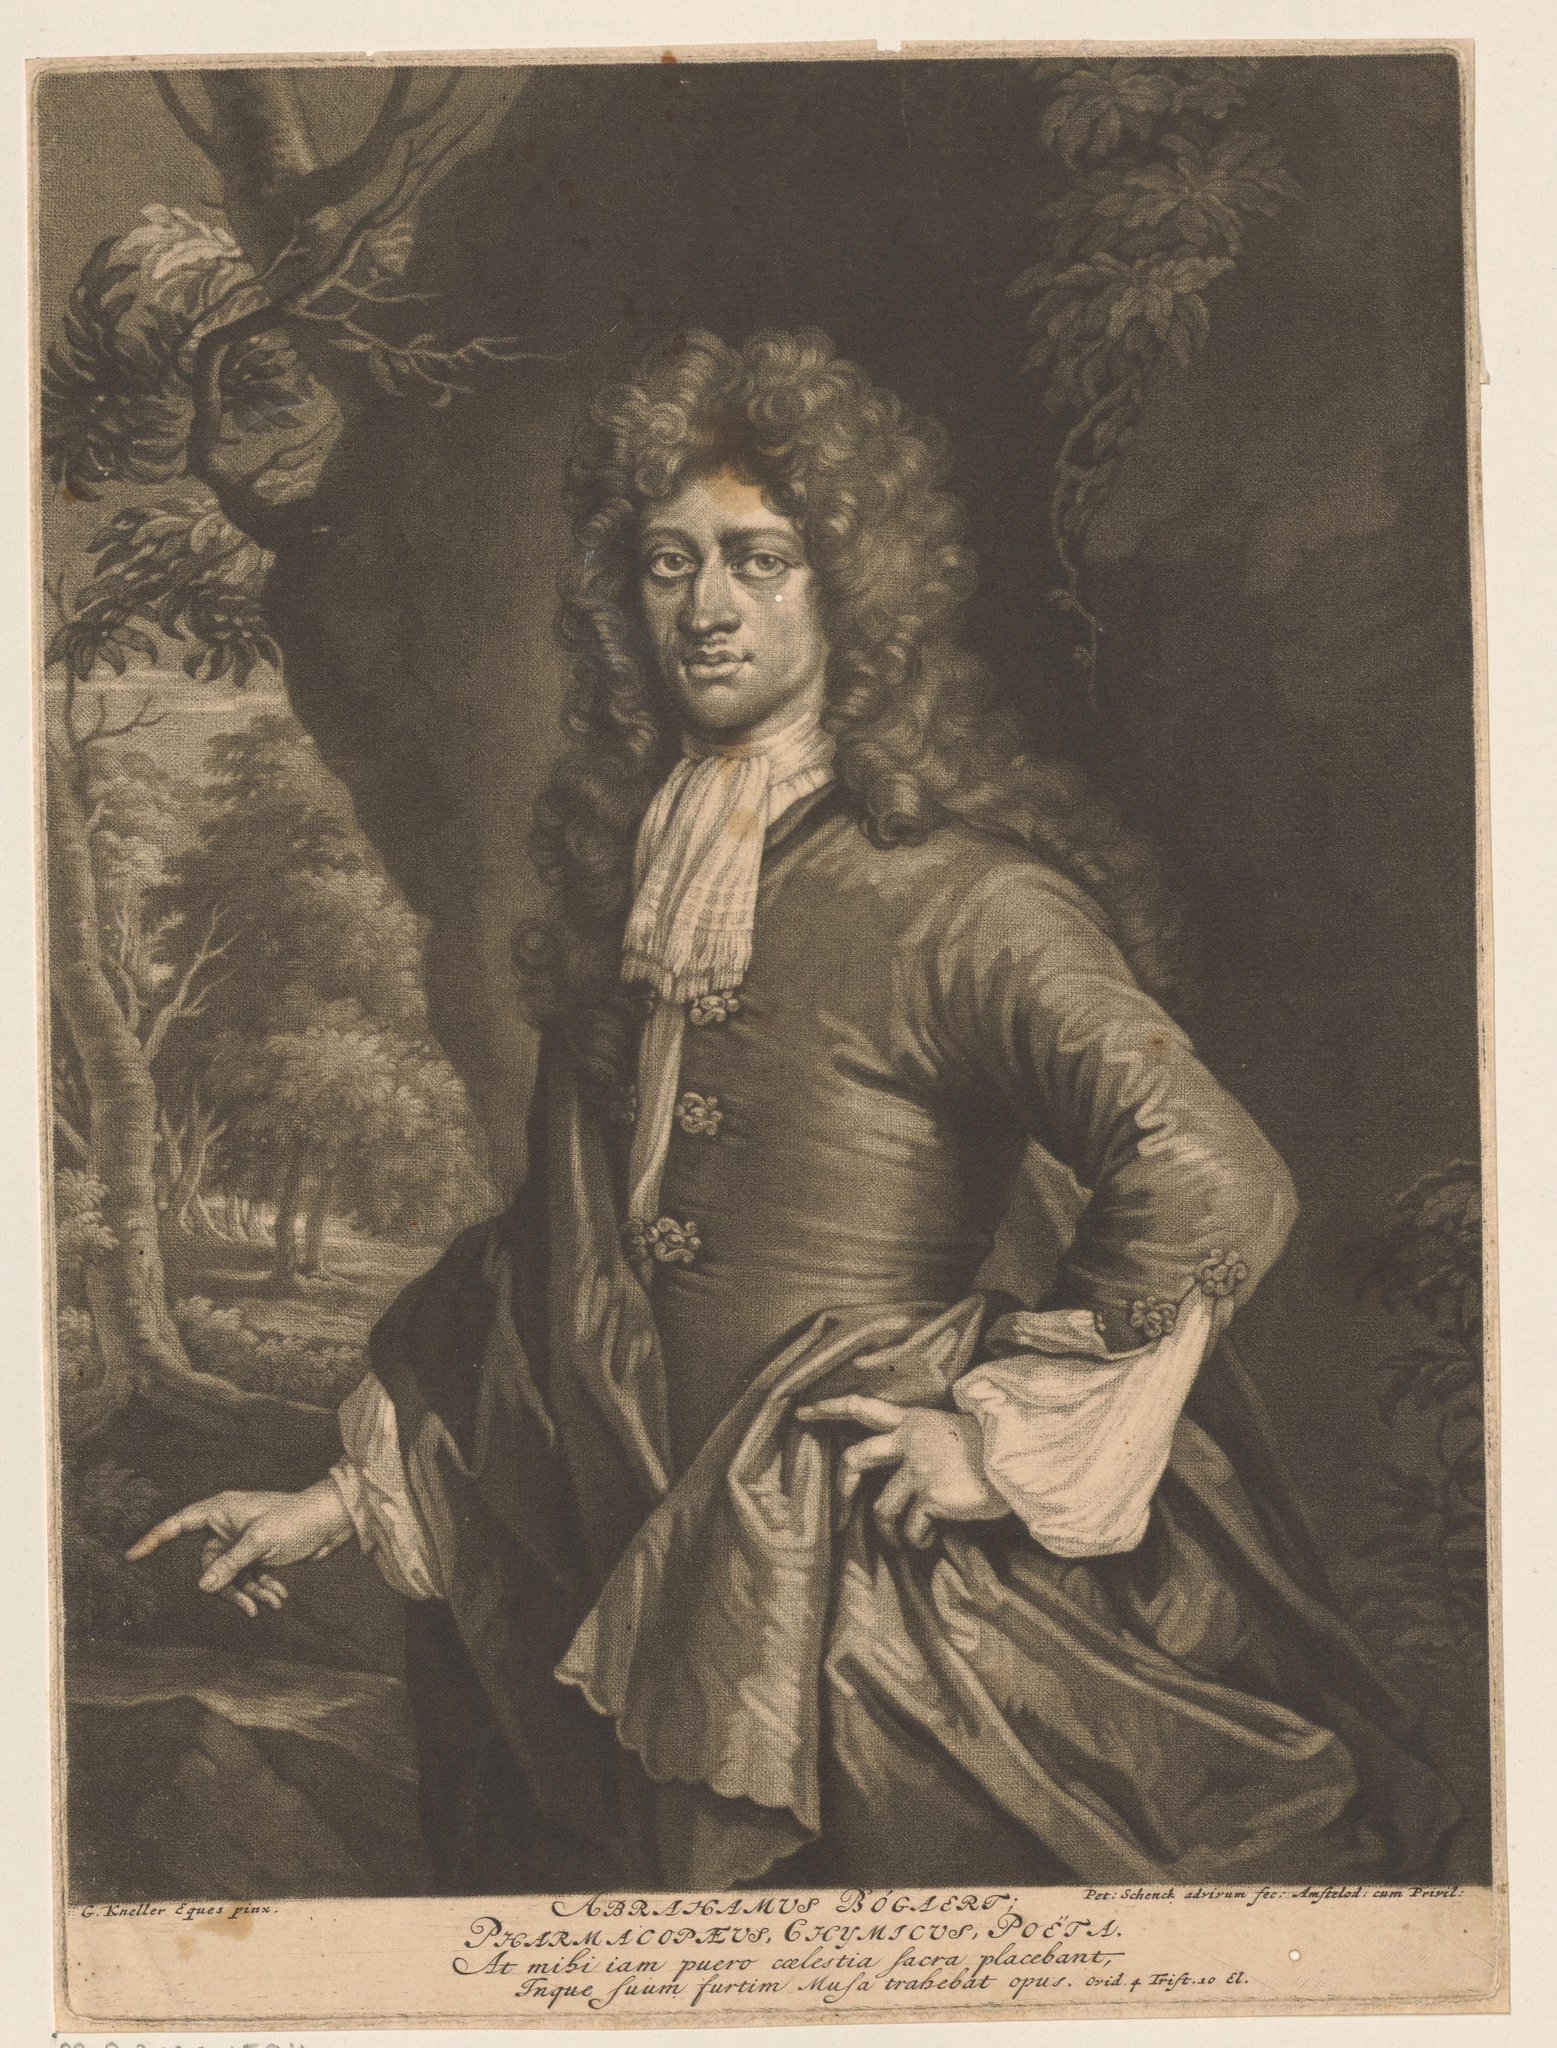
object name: print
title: Portret van Abraham Bogaert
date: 1675-1711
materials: paper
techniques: engraving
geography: amsterdam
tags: amsterdam, abraham bogaert, historical persons, portrait of a writer